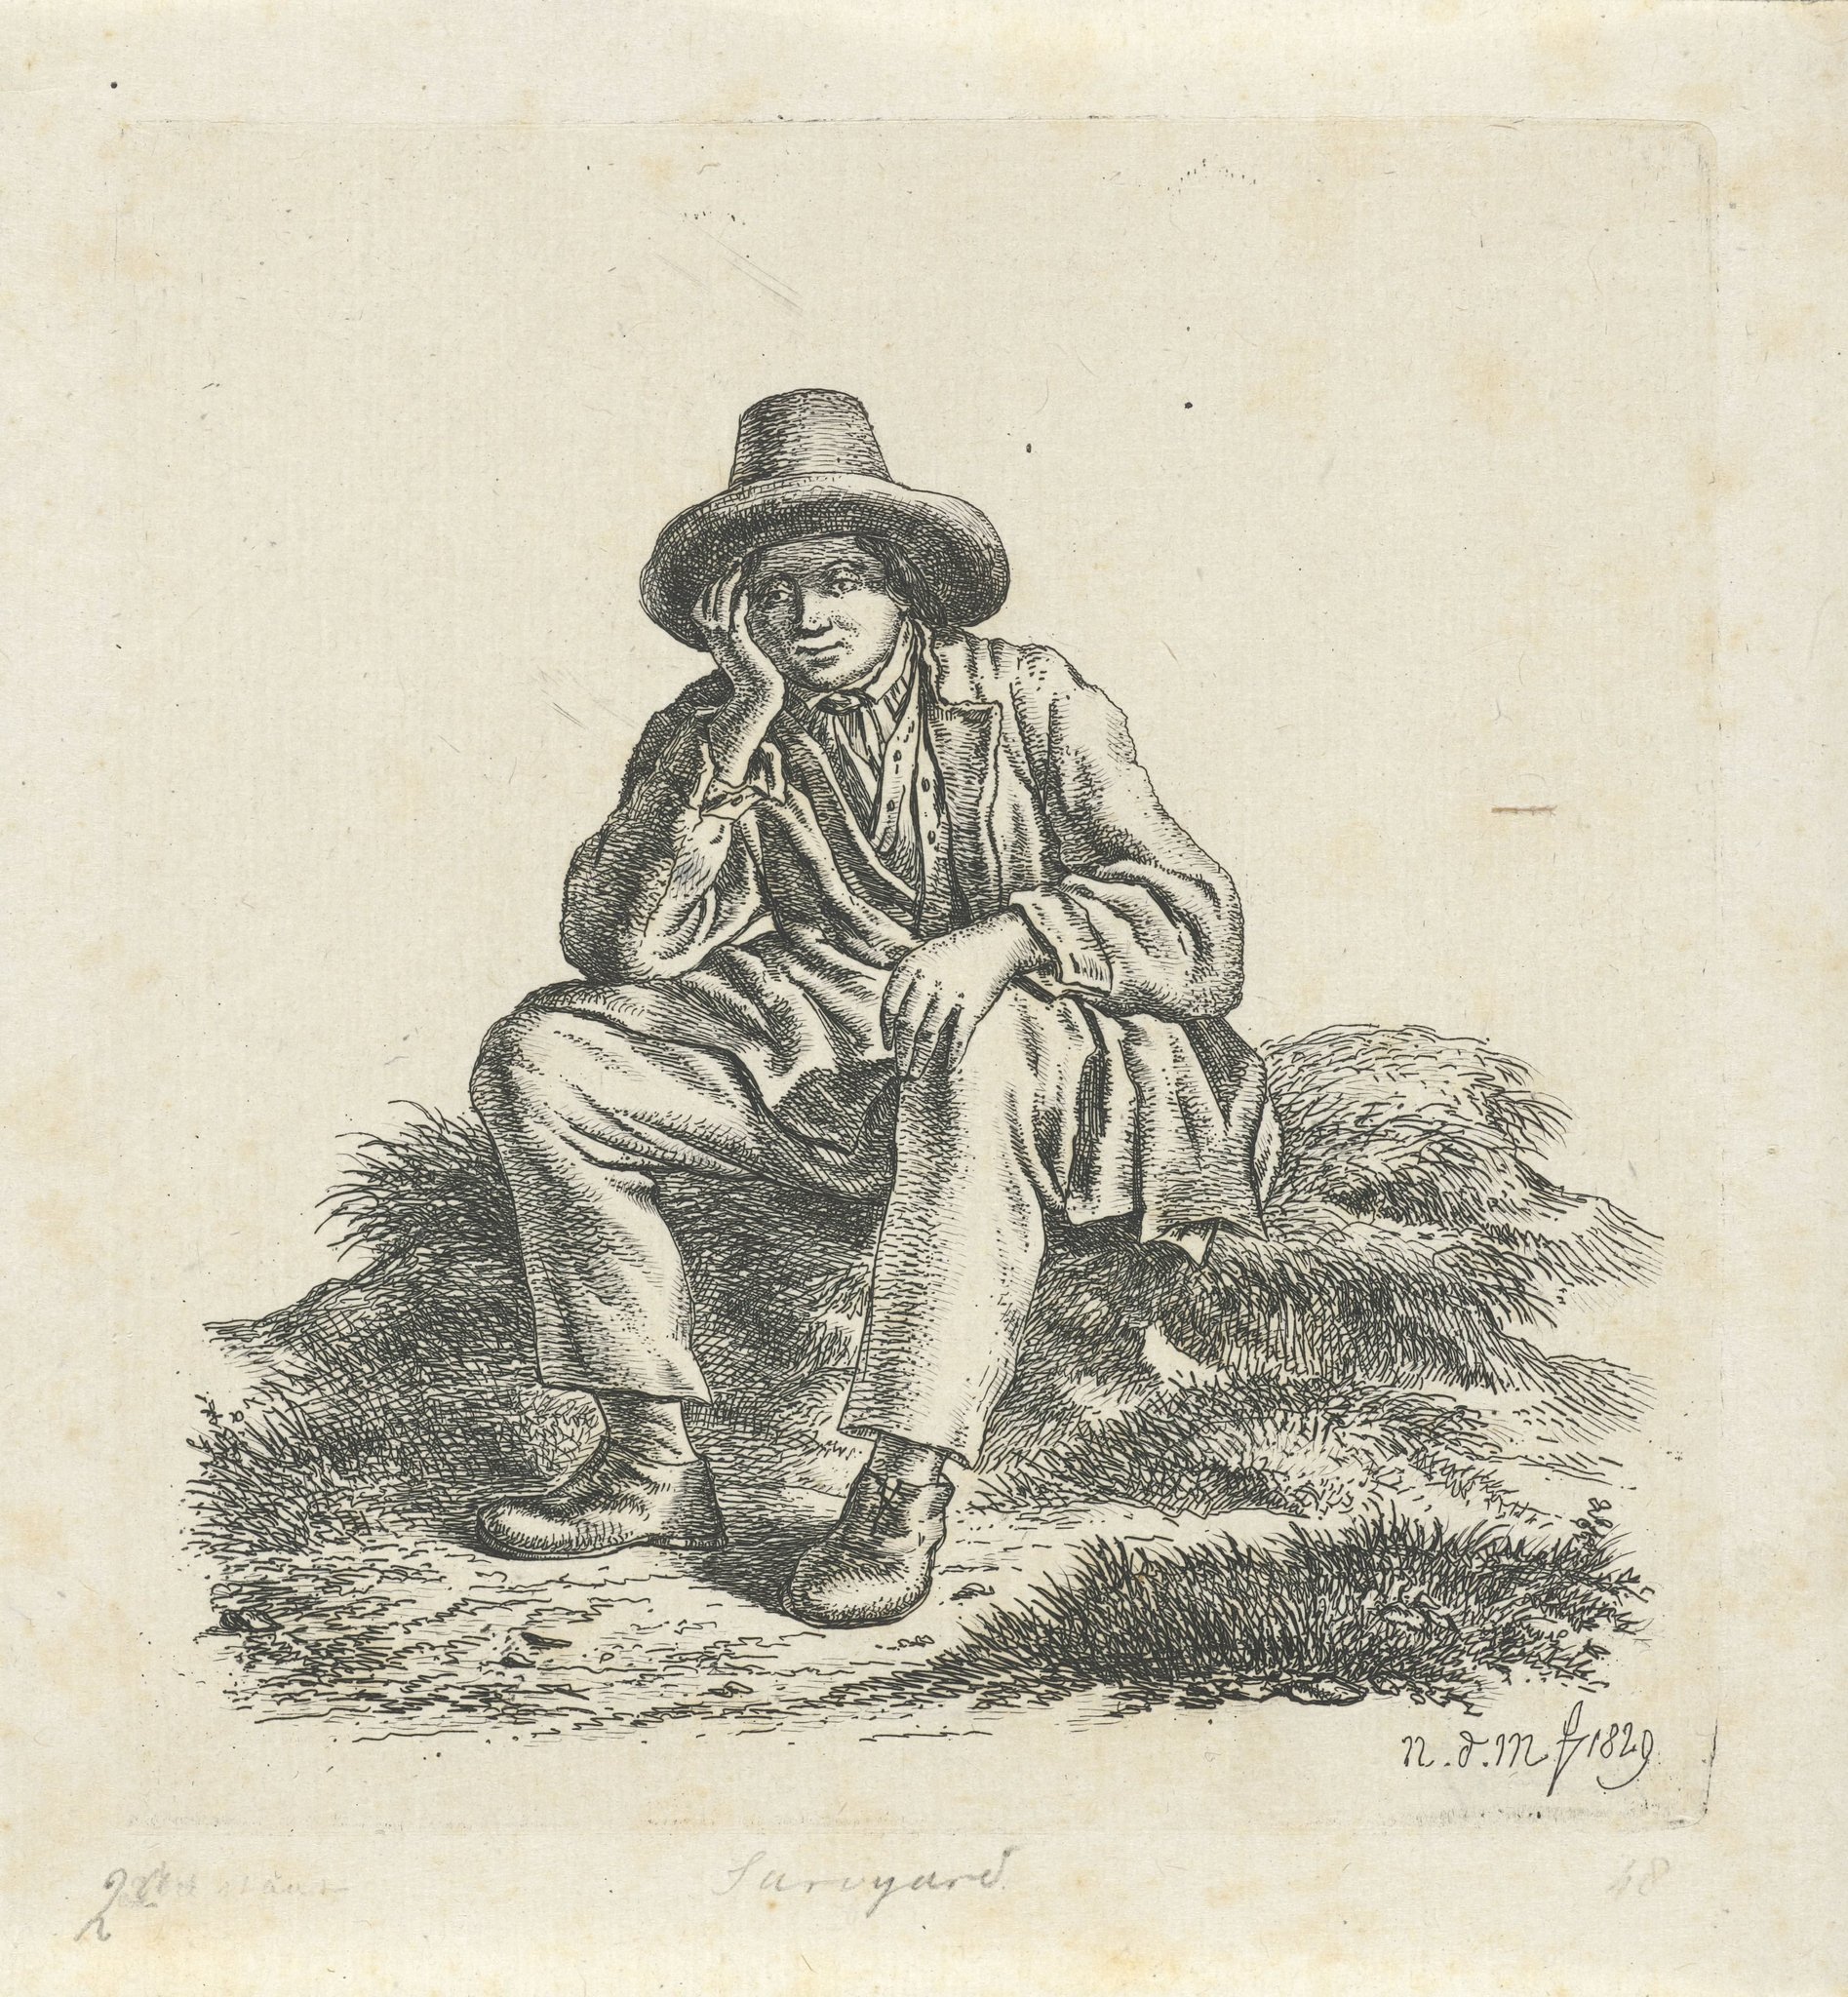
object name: print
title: Zittende man, zijn hoofd ondersteunend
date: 1829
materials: paper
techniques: etching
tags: sitting figure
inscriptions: collector's mark: Lugt 2227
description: Zittende man in een landschap. Zijn hoofd wordt ondersteund door zijn rechterhand, de elleboog op zijn bovenbeen.